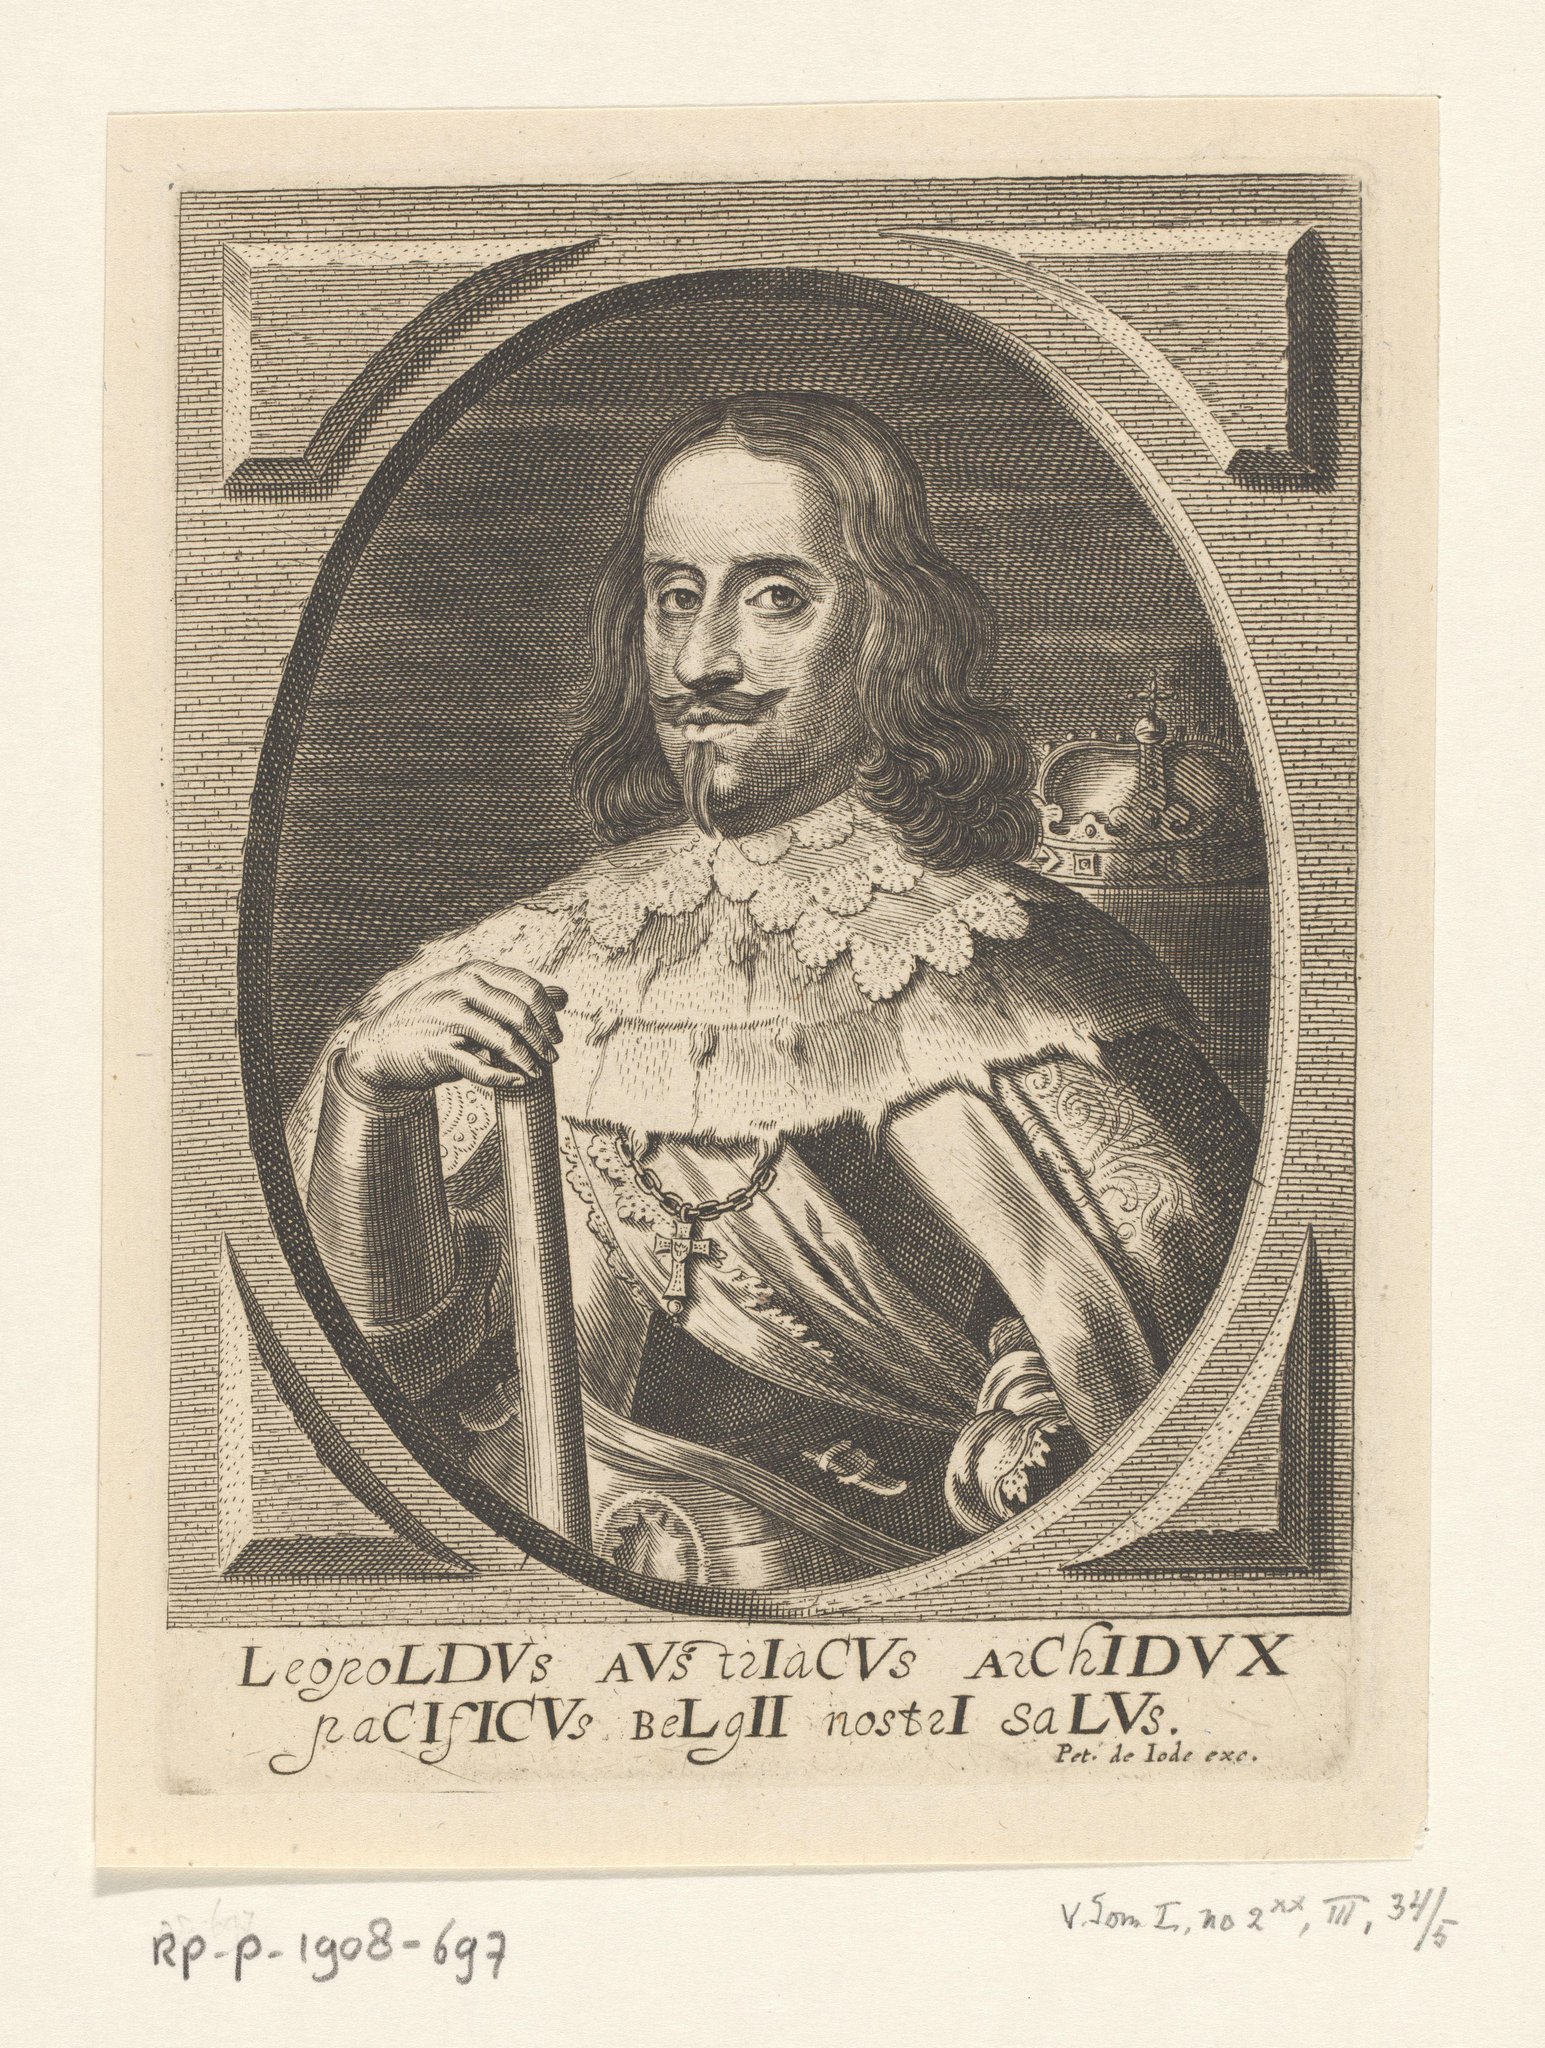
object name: print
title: Portret van Leopold Willem van Oostenrijk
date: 1647-1651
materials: paper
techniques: engraving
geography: antwerp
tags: vienna, leopold willem van oostenrijk (landvoogd der zuidelijke nederlanden), crown (symbol of sovereignty), armour, historical persons, ruler, sovereign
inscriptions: collector's mark: Lugt 2228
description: De prent is gebruikt voor De Jode's serie Theater van portretten (zie New Hollstein), tussen 1638 en 1651 in verschillende edities uitgegeven onder de titel 'Theatrum Principum, Ducum et Comitum (...)' en 'Theatrum pontificum, imperatorum, regum, ducum, principum, etc.'